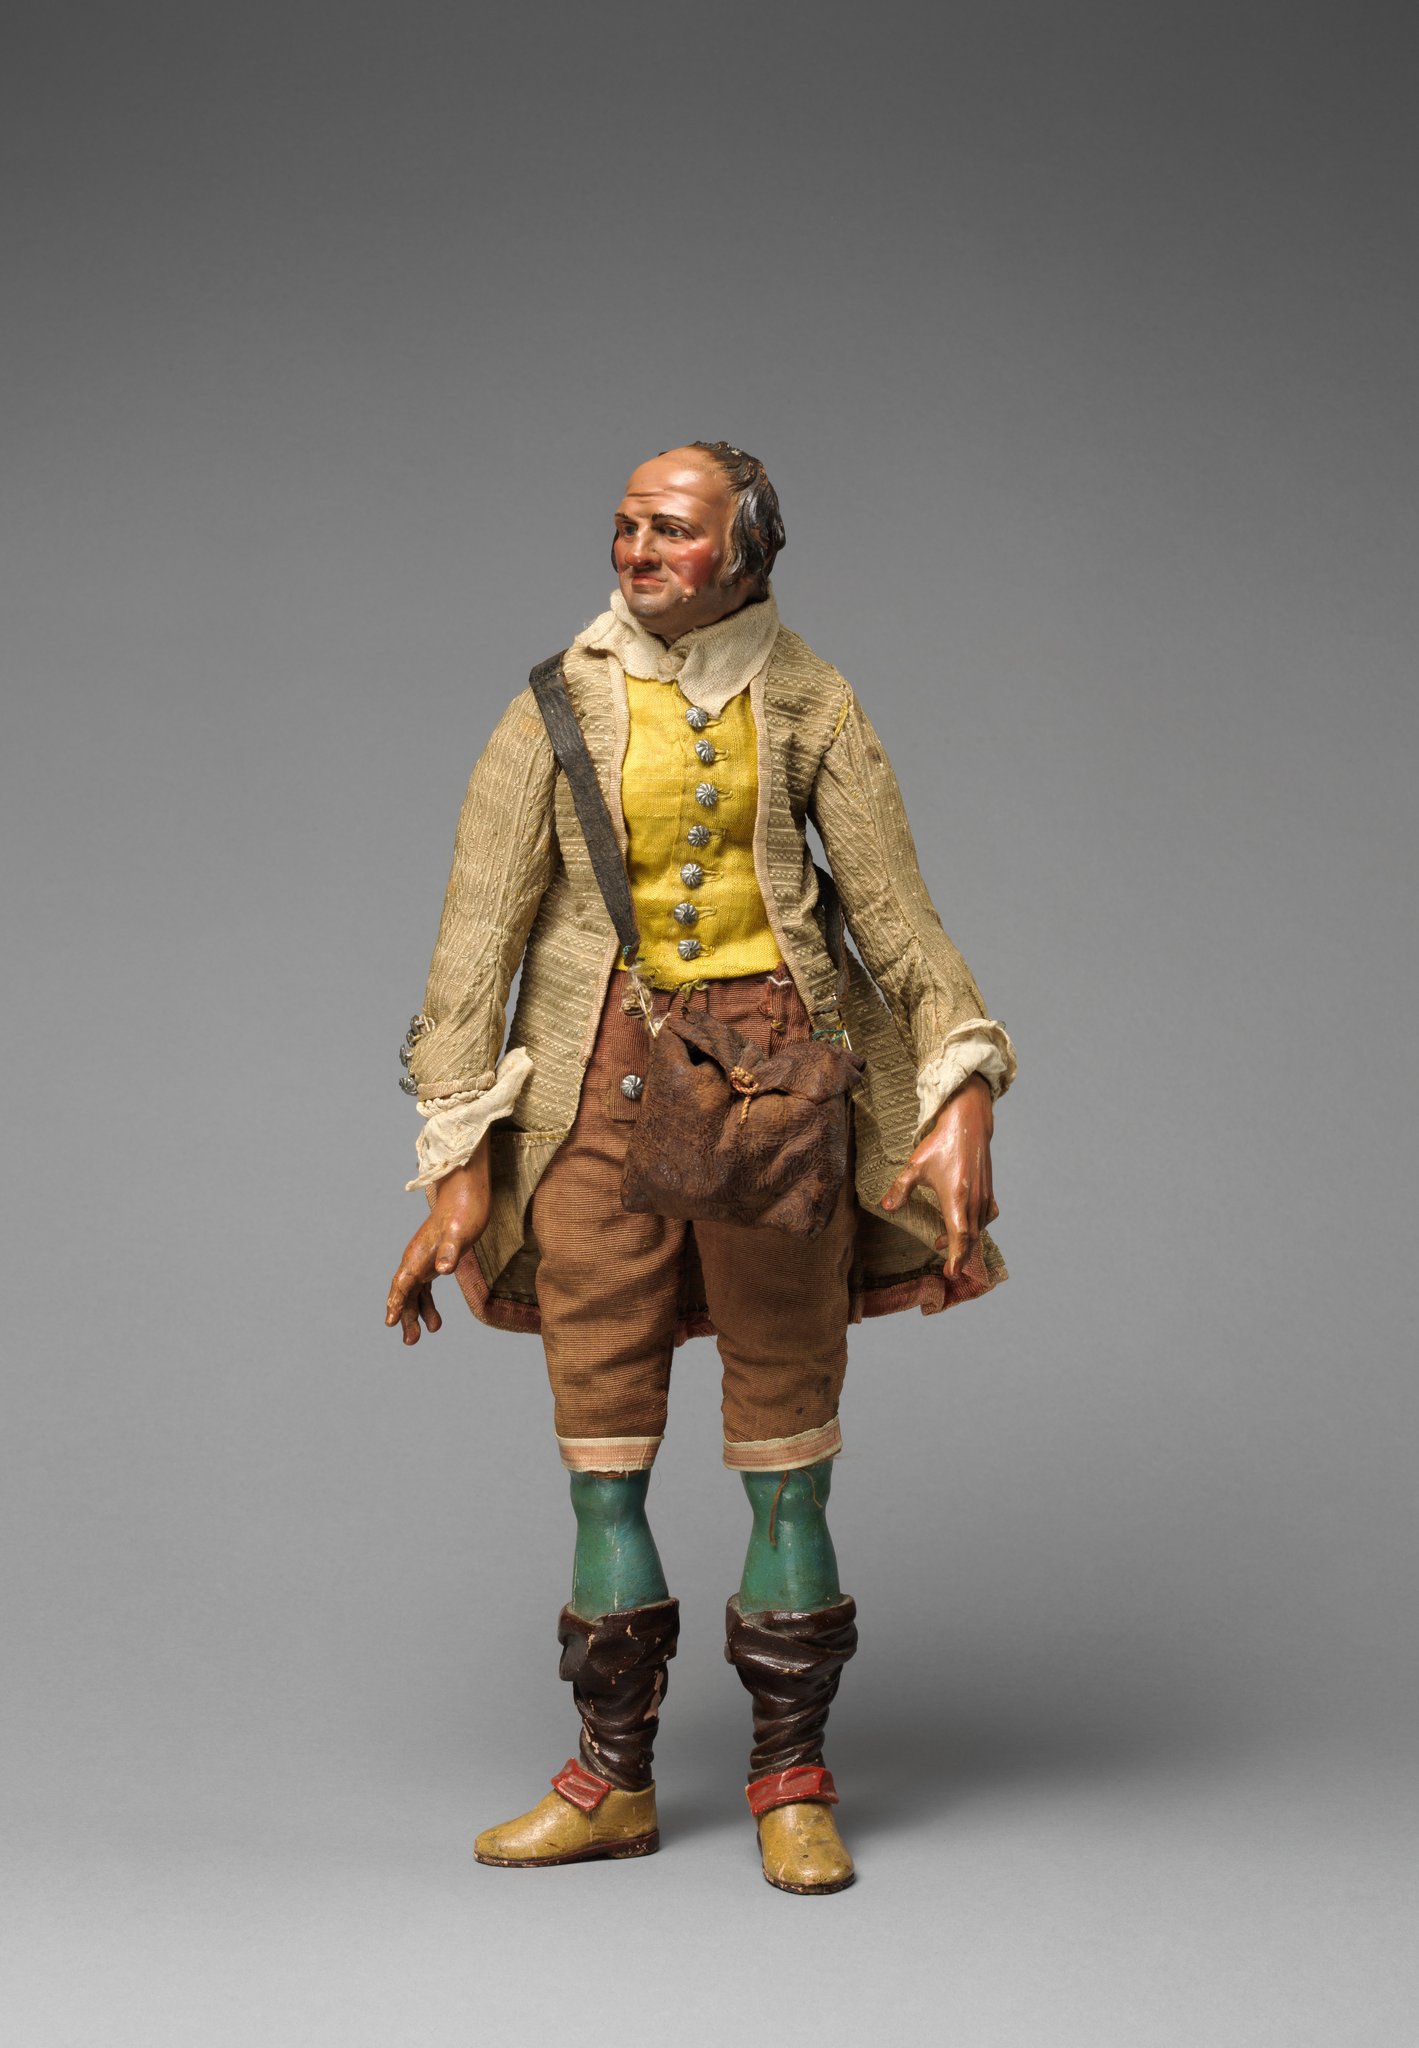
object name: crèche figure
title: Gentleman with yellow vest, tan/maroon knickers, beige coat, falling down stockings over blue legs, and shoulder bag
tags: men